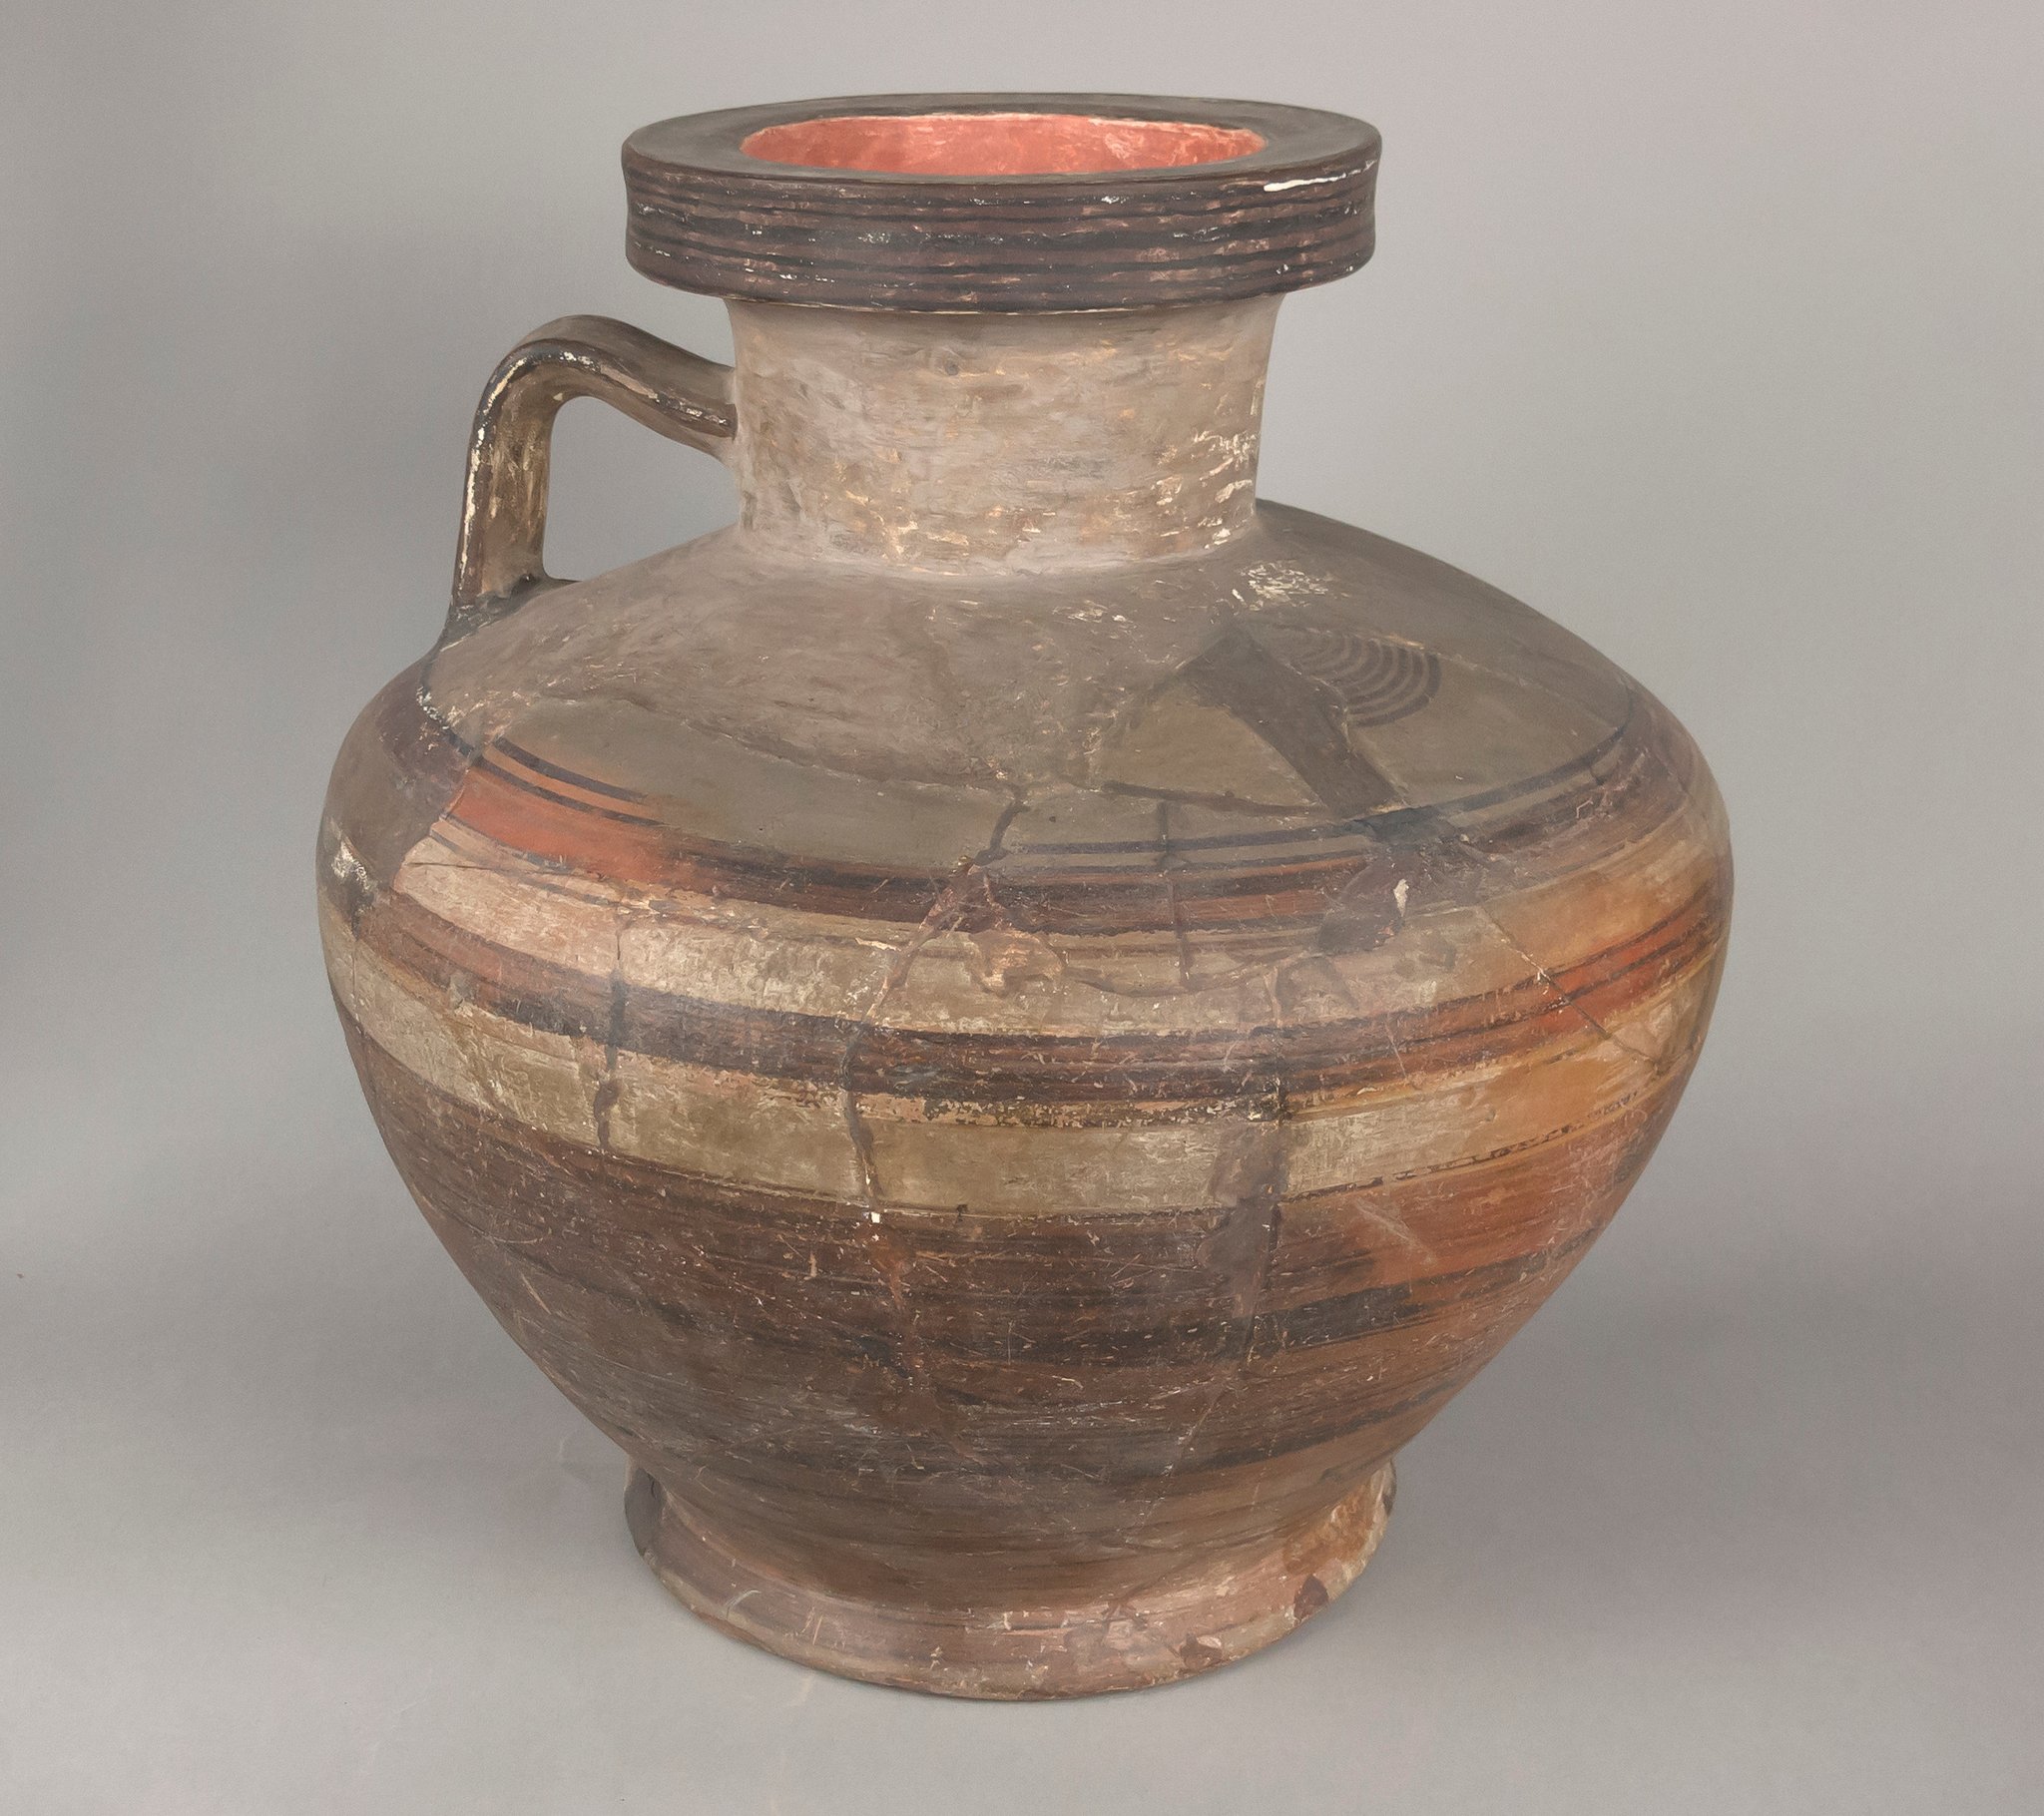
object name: vase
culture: greek or lydian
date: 900-30 BCE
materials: terracotta